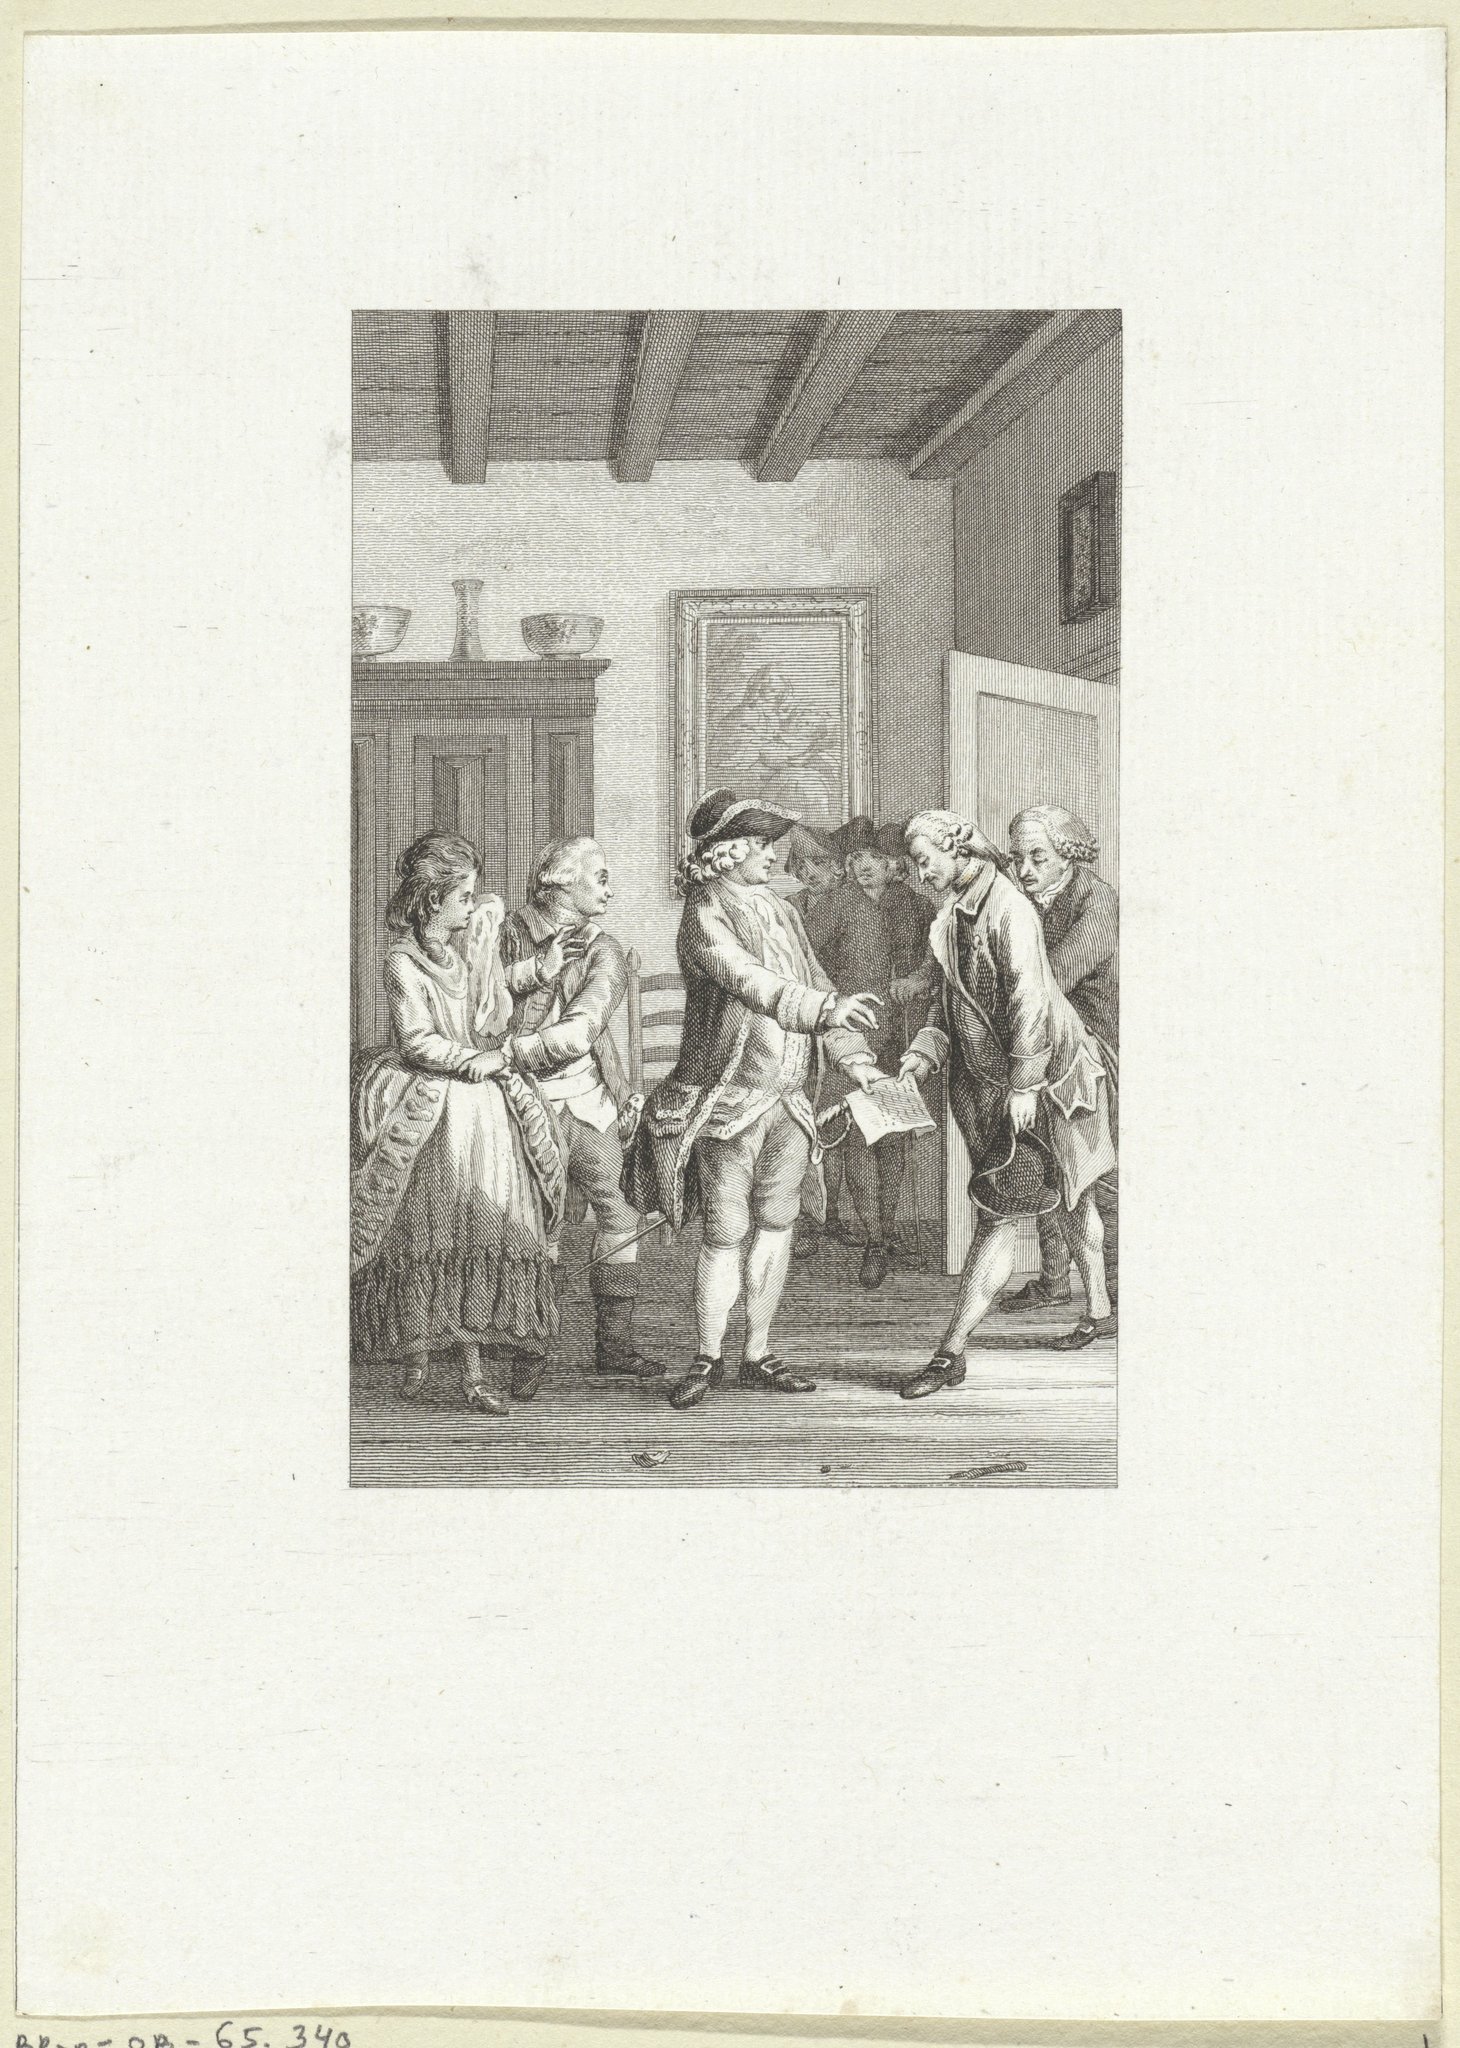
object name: print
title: In een vertrek neemt een man een brief in ontvangst van een andere man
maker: reinier vinkeles (i)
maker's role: draughtsman, print maker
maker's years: 1741-1816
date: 1782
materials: paper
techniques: engraving, etching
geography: amsterdam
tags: delivering; receiving (~ postal matter), picture, painting, letter, envelope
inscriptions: collector's mark: Lugt 240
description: Proefdruk van illustratie in: Pigault-Lebrun, Charles Antoine Guillaume. Karel en Karolina. Amsterdam: Pieter Meijer, 1782.